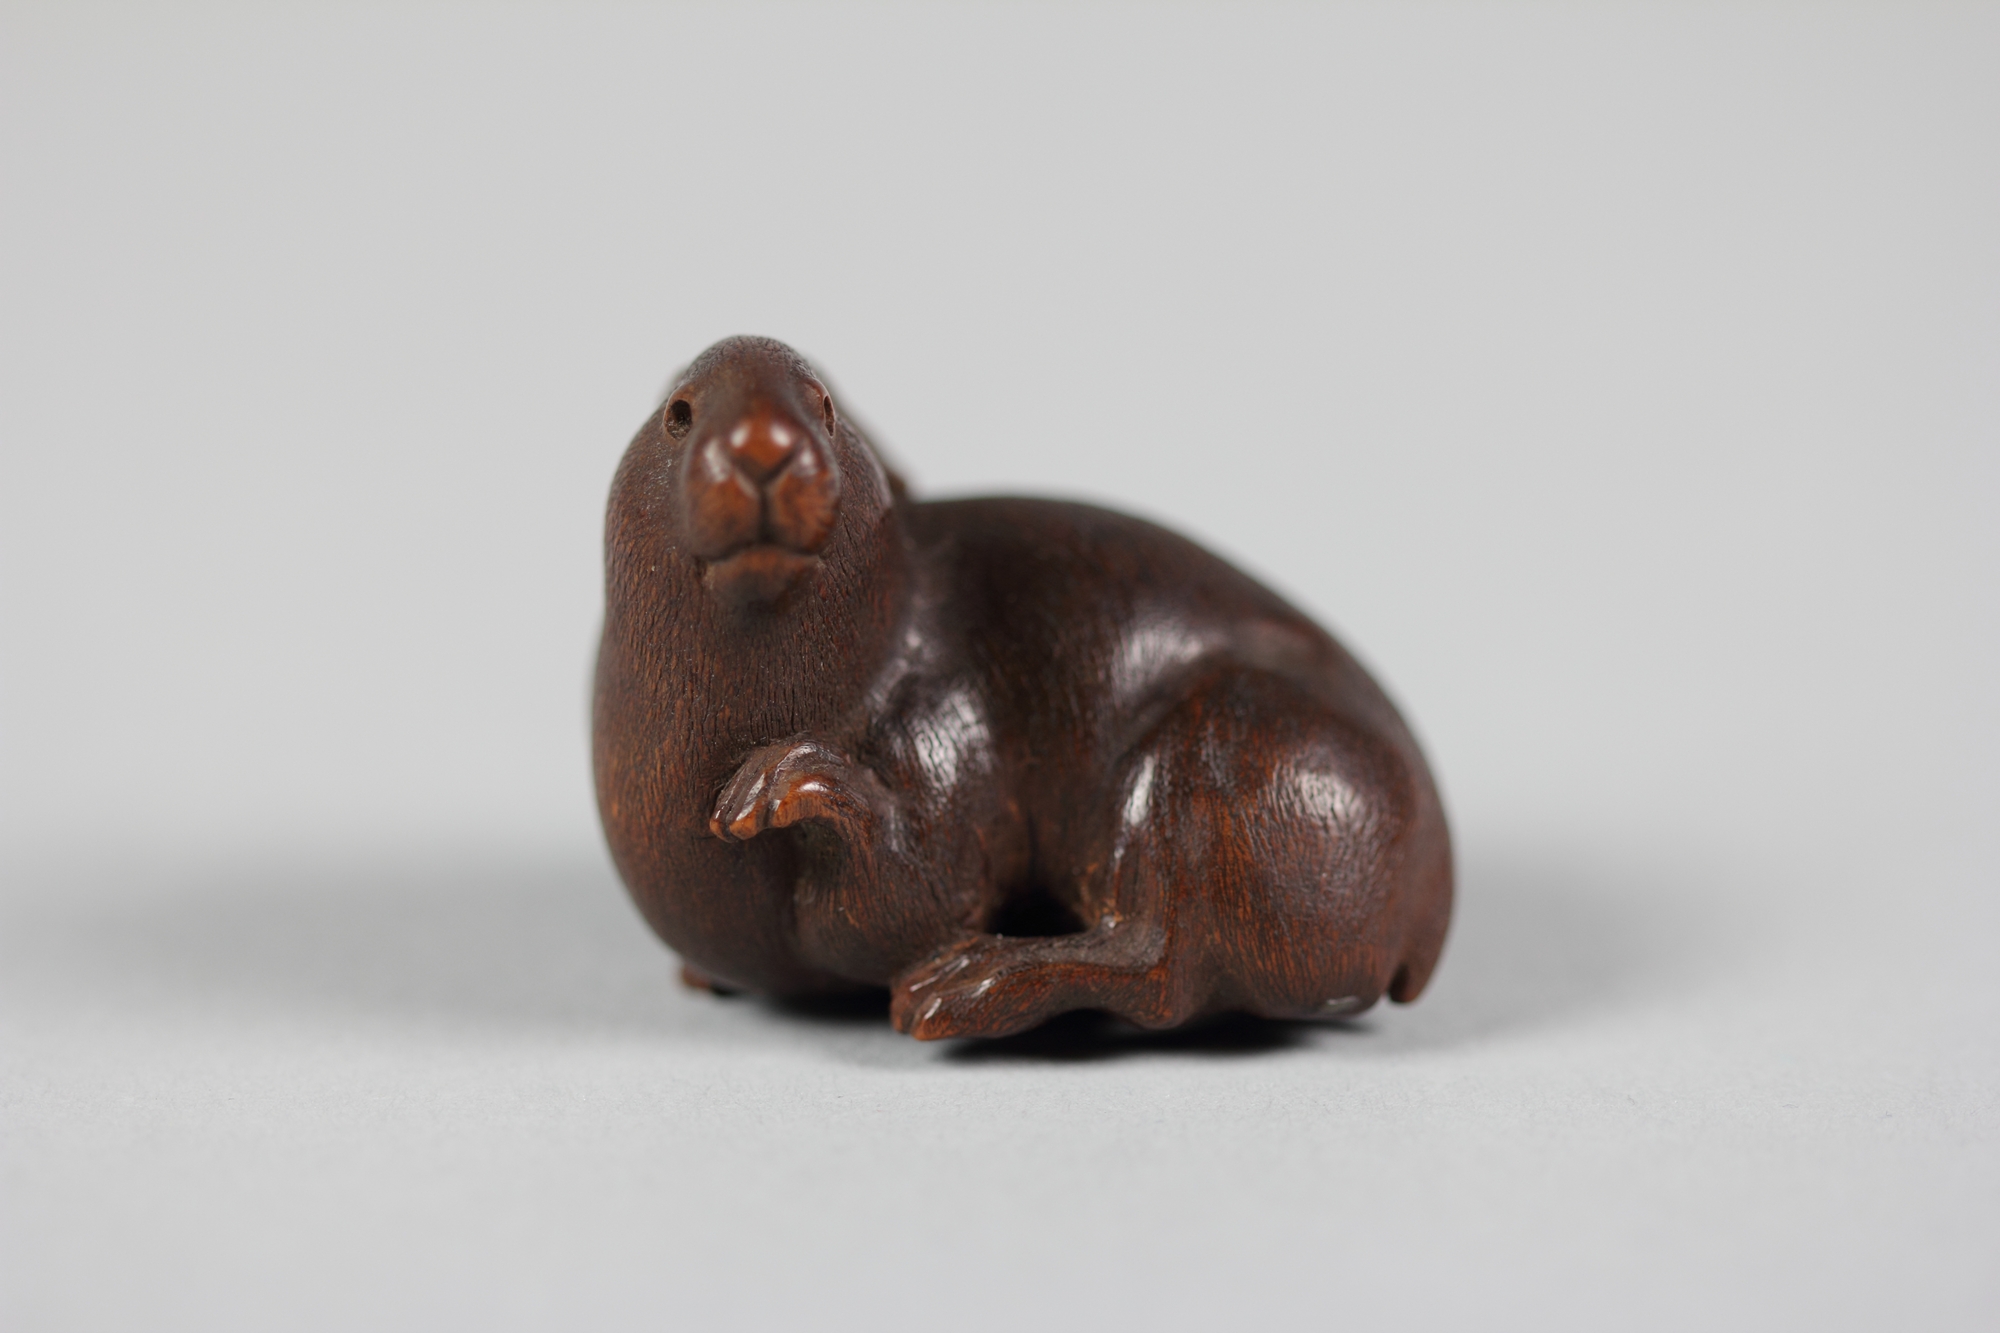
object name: netsuke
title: Netsuke of Rabbit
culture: japanese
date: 1801-1900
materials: wood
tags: rabbits